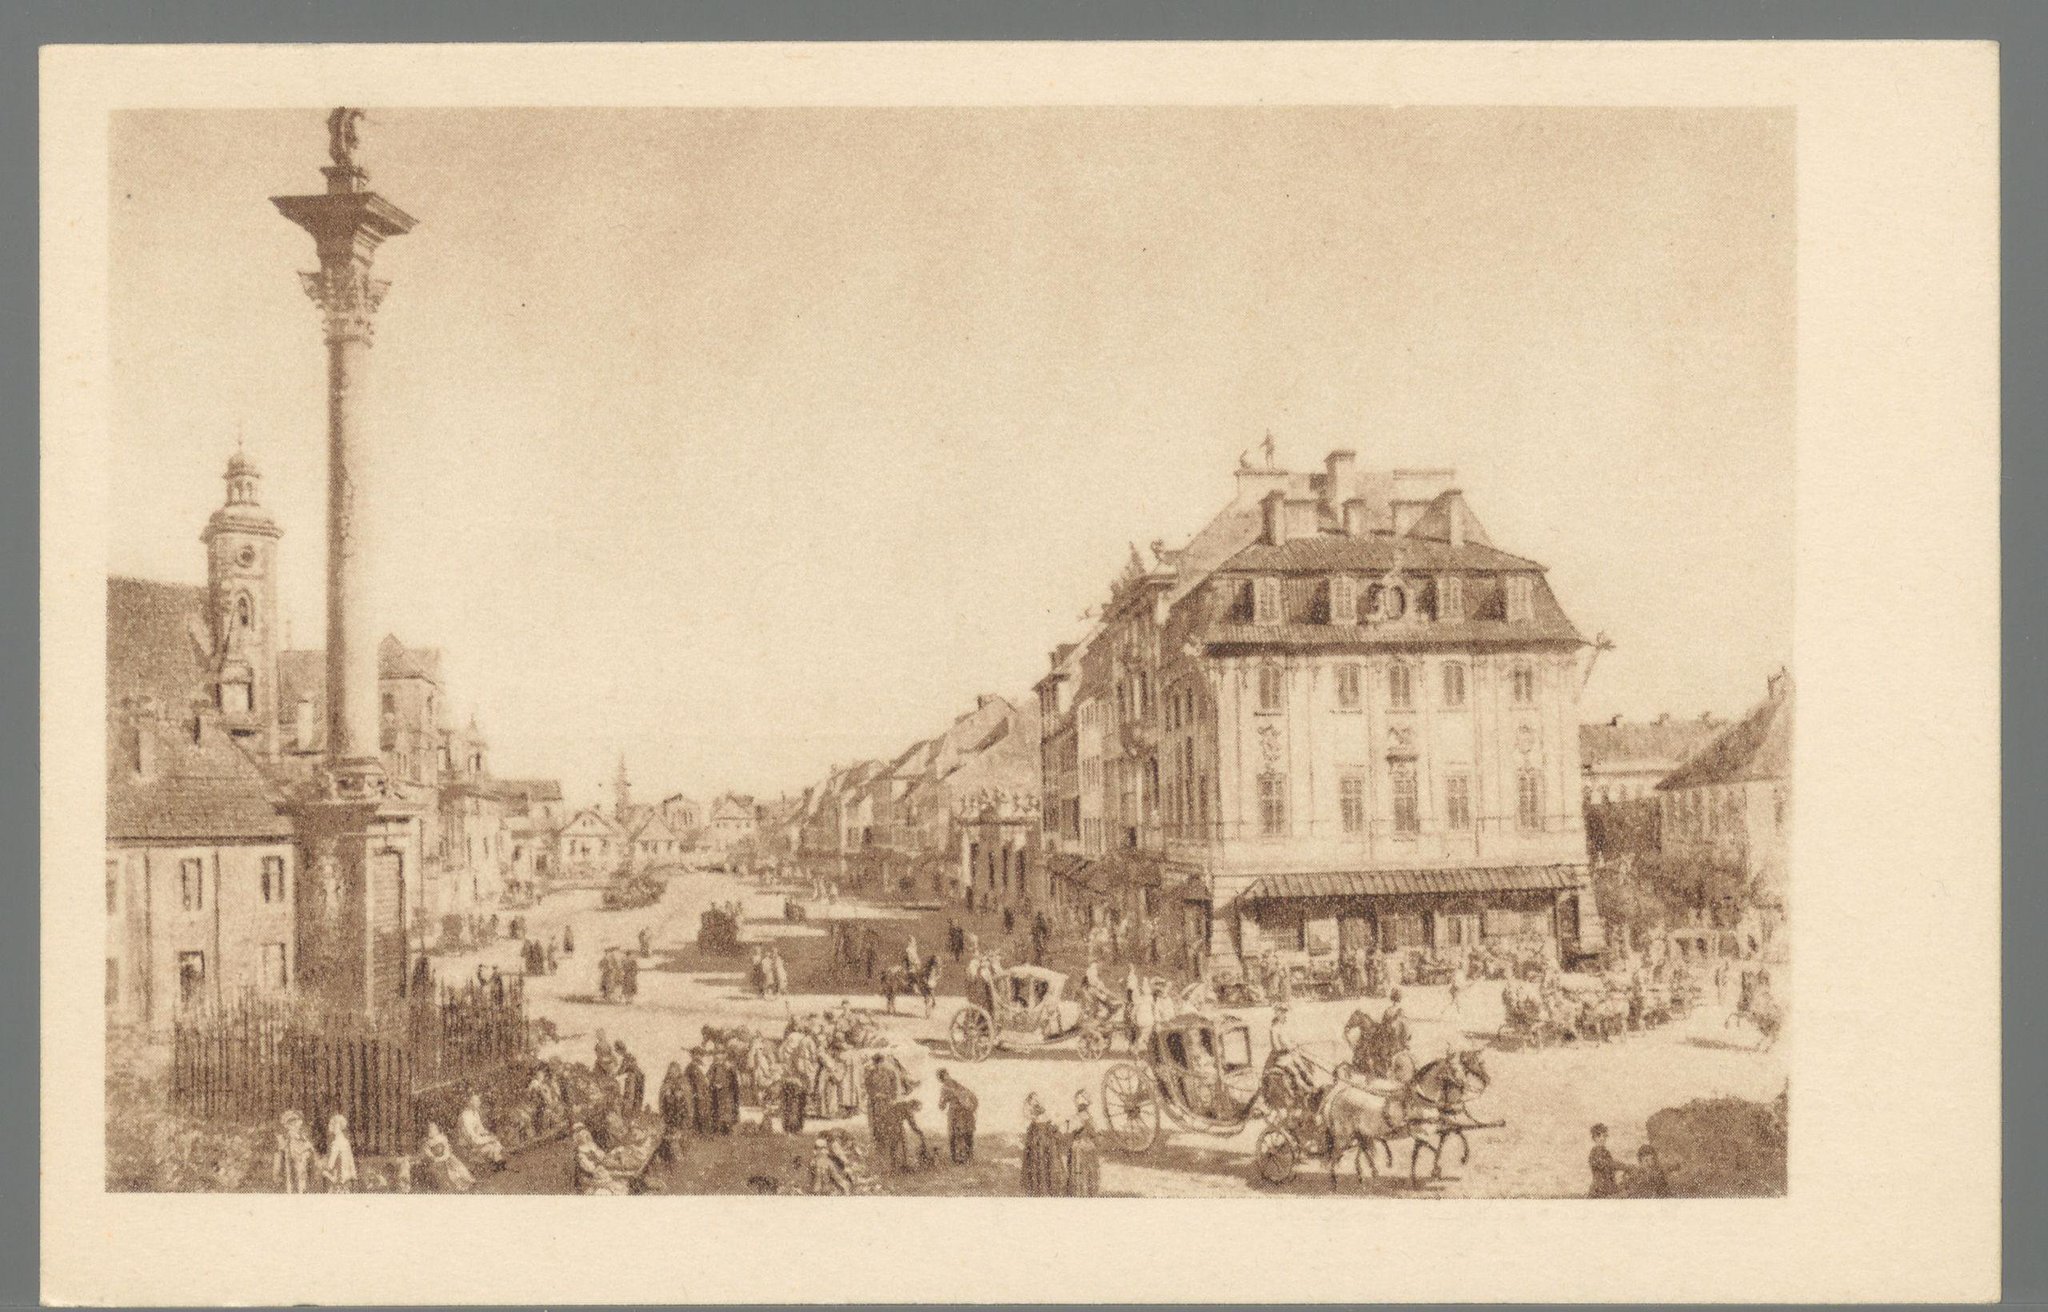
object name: reproduction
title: Krakowskie Przedmieście od strony Placu Zamkowego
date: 1920-1960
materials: cardboard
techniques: rotogravure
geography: warsaw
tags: avenue, boulevard, promenade, esplanade (+ city(-scape) with figures, staffage), monument, statue